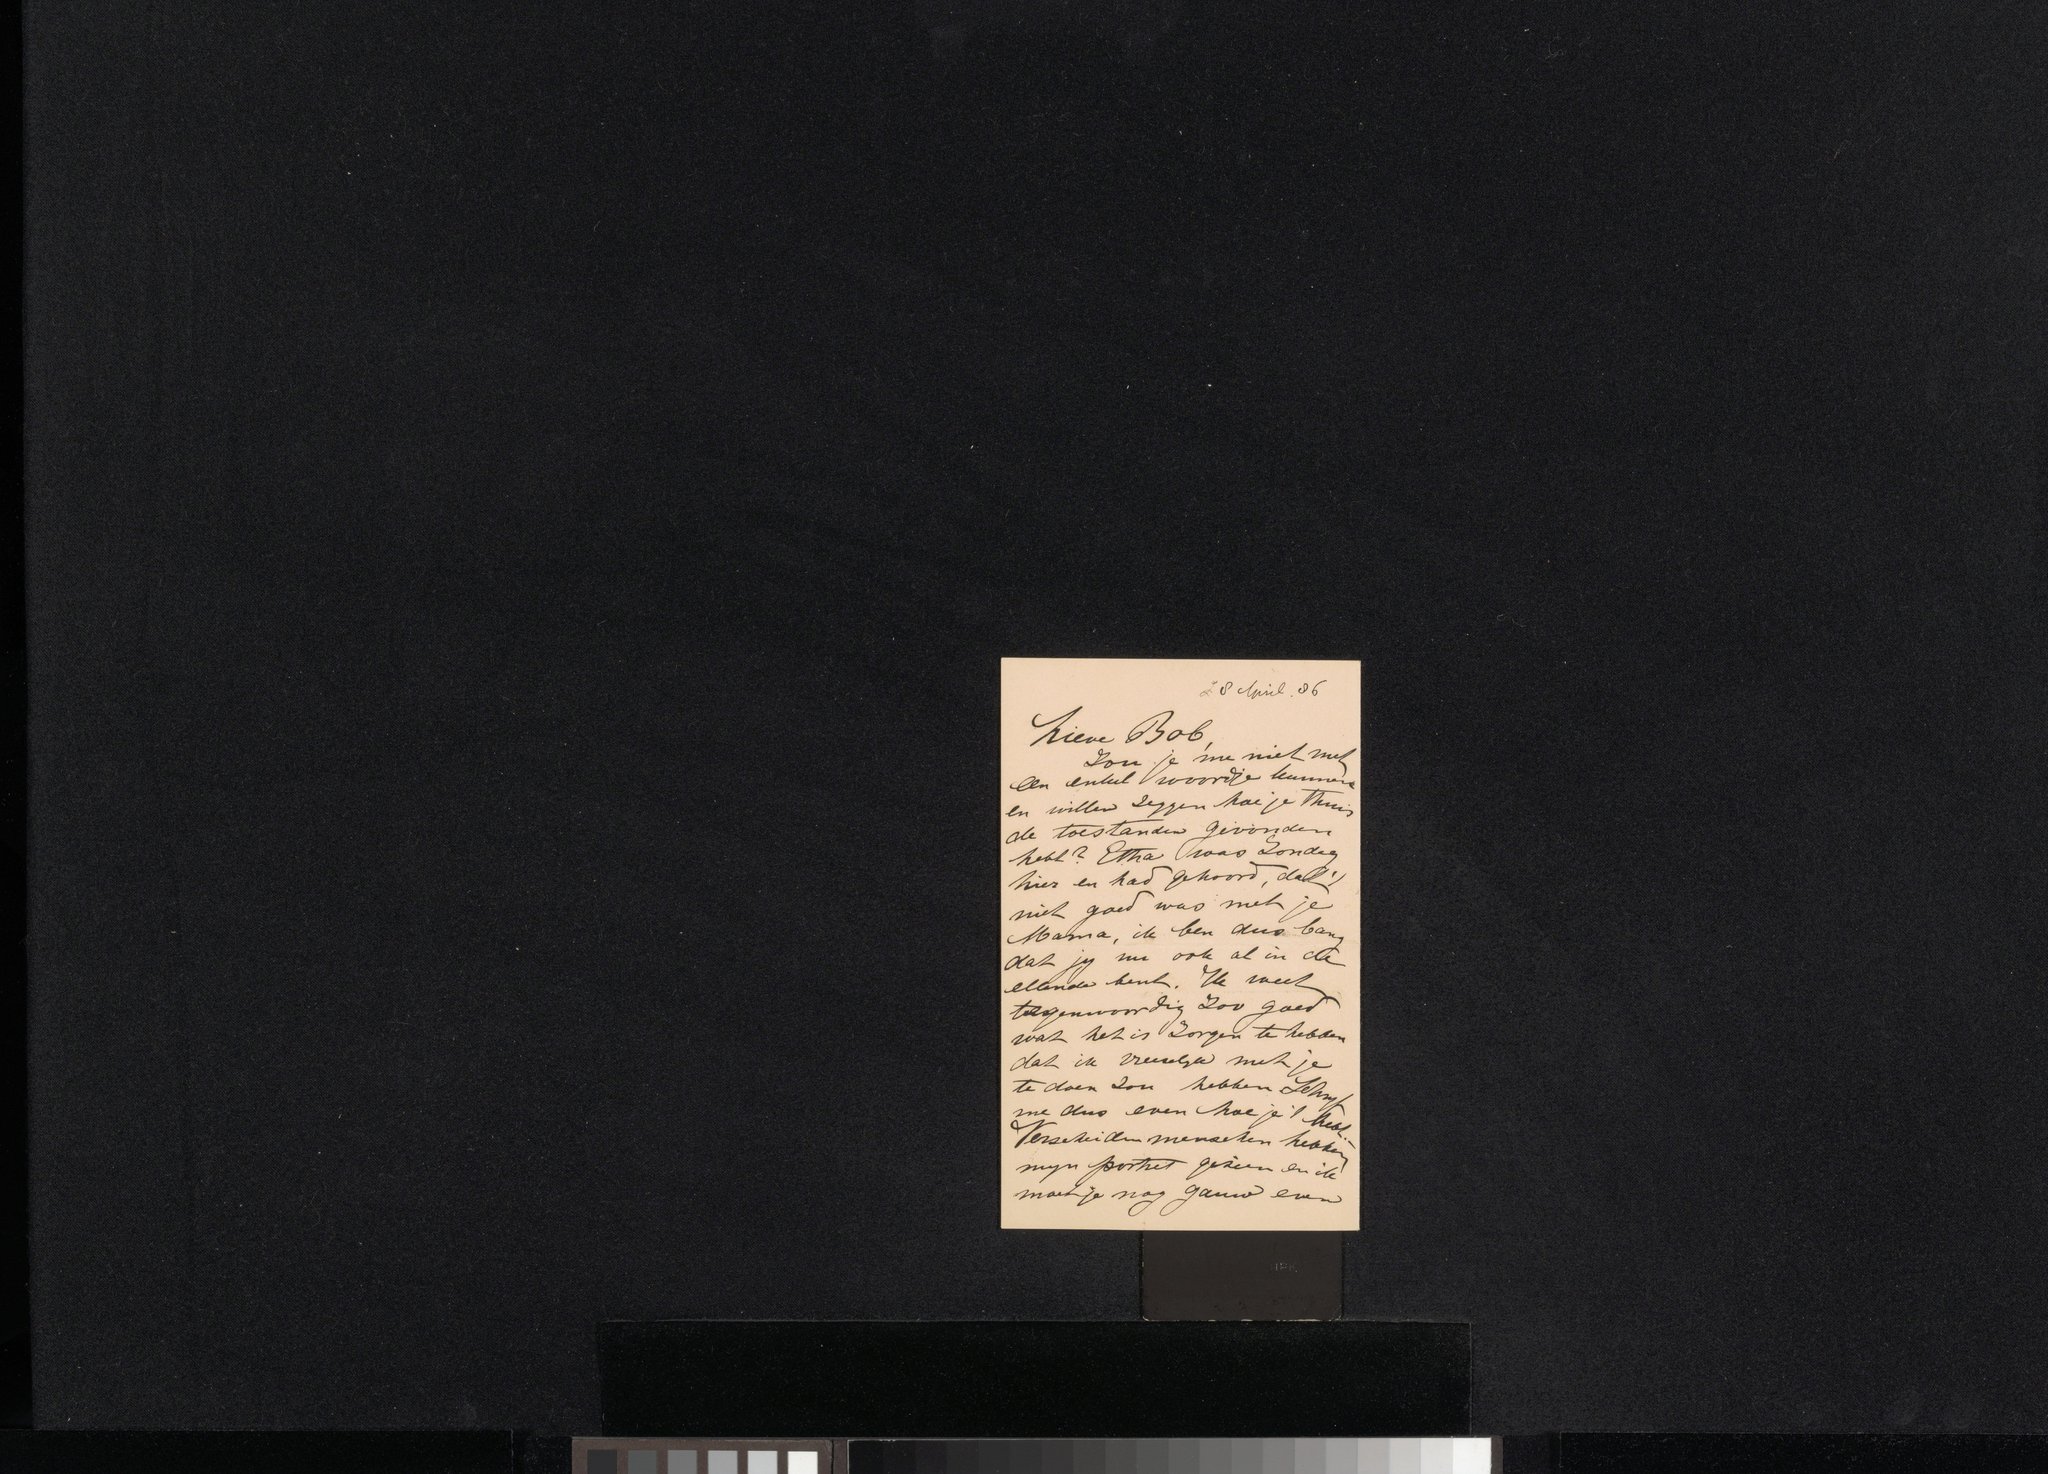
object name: letter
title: Brief aan Jan Veth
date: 1886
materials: ink, paper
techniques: pen, writing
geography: cologne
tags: dordrecht, painter, designer, jan veth, diseases, historical persons (portraits and scenes from the life)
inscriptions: collector's mark: ‘RPK’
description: Brief bevat carte-de-visite van Wally Moes.